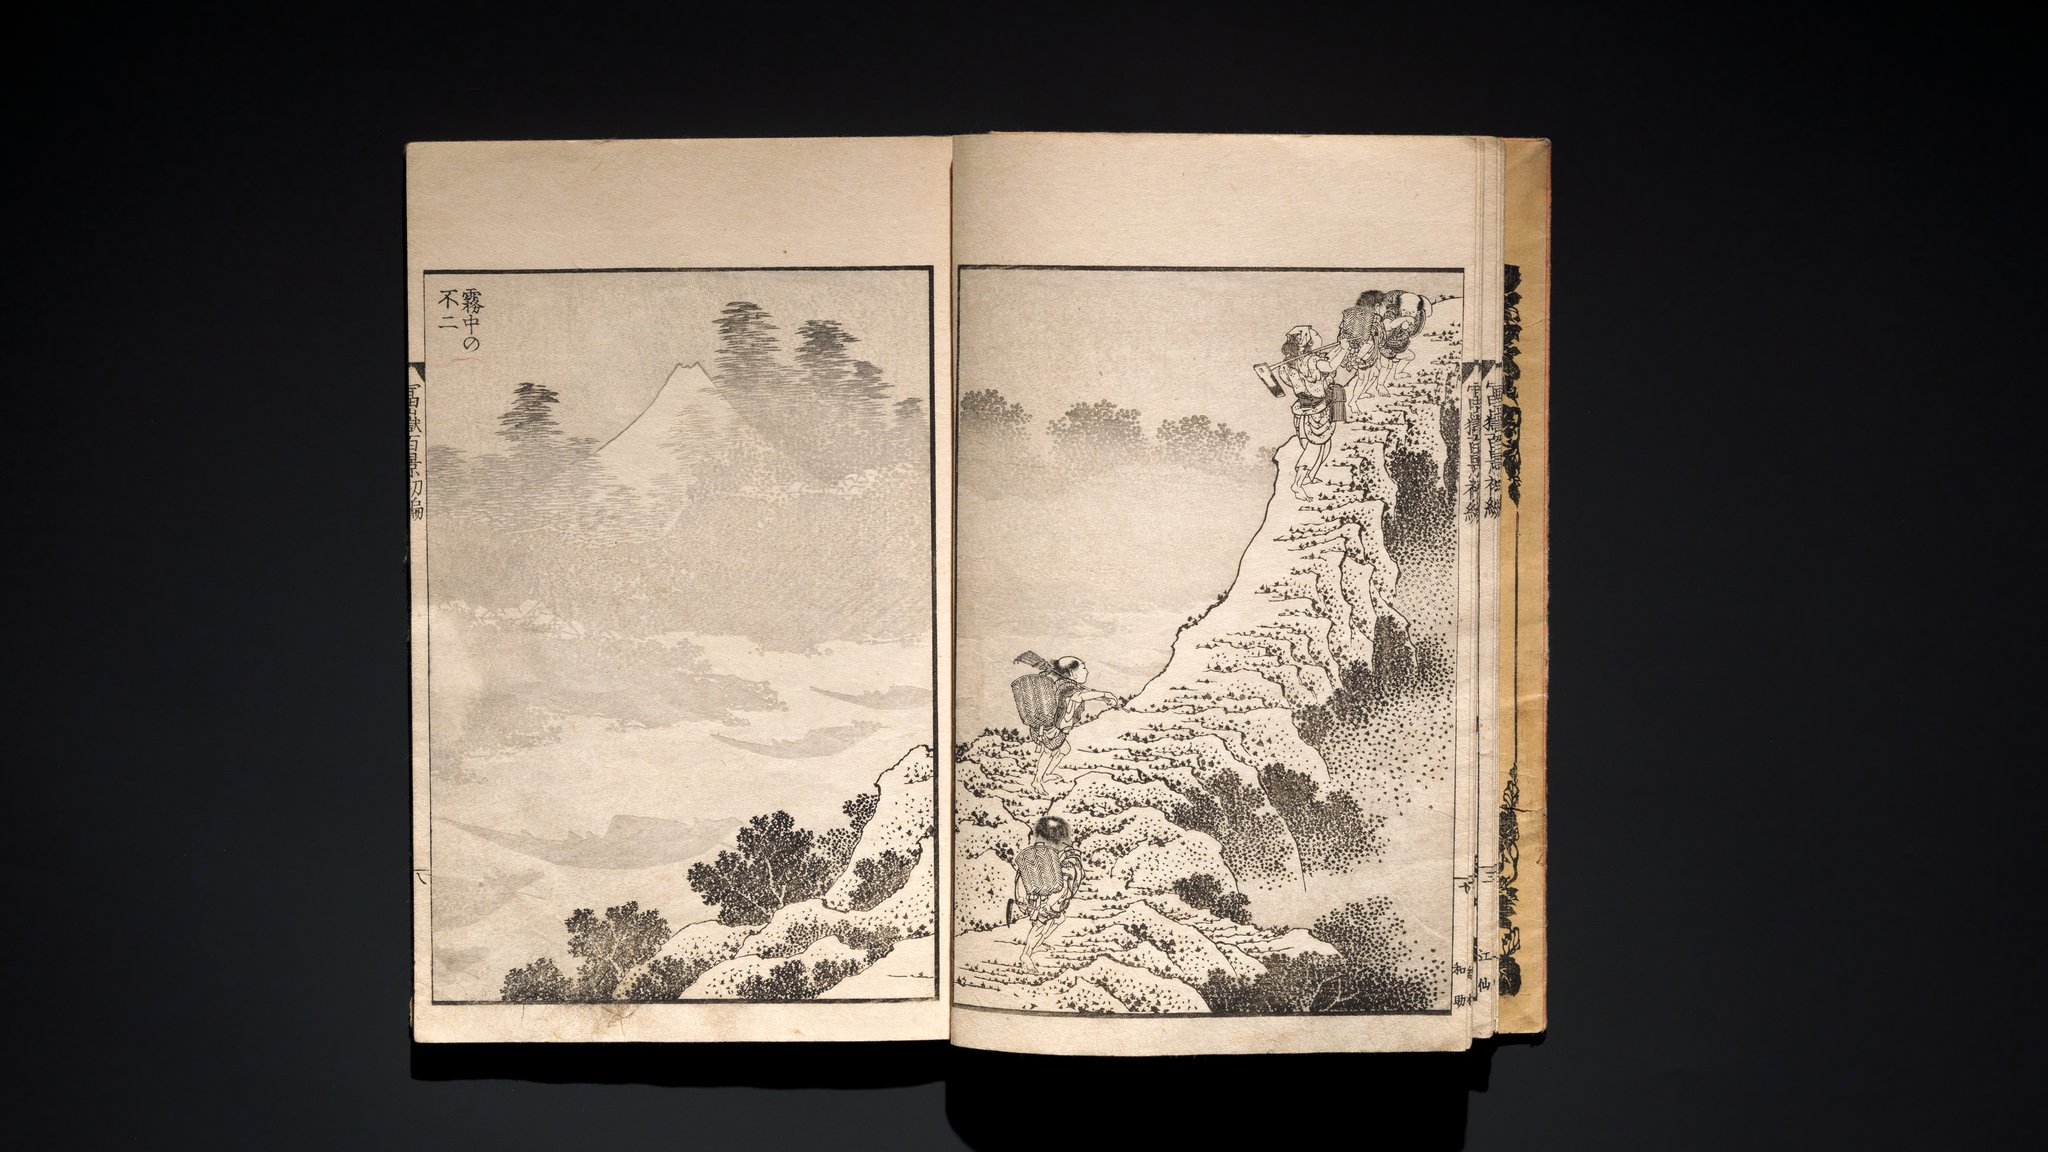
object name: illustrated book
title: One Hundred Views of Mount Fuji (Fugaku hyakkei) 富嶽百景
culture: japanese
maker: katsushika hokusai 葛飾北斎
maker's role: artist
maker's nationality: japanese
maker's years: 1760-1849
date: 1849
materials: ink, paper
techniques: woodblock print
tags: human figures,volcanoes